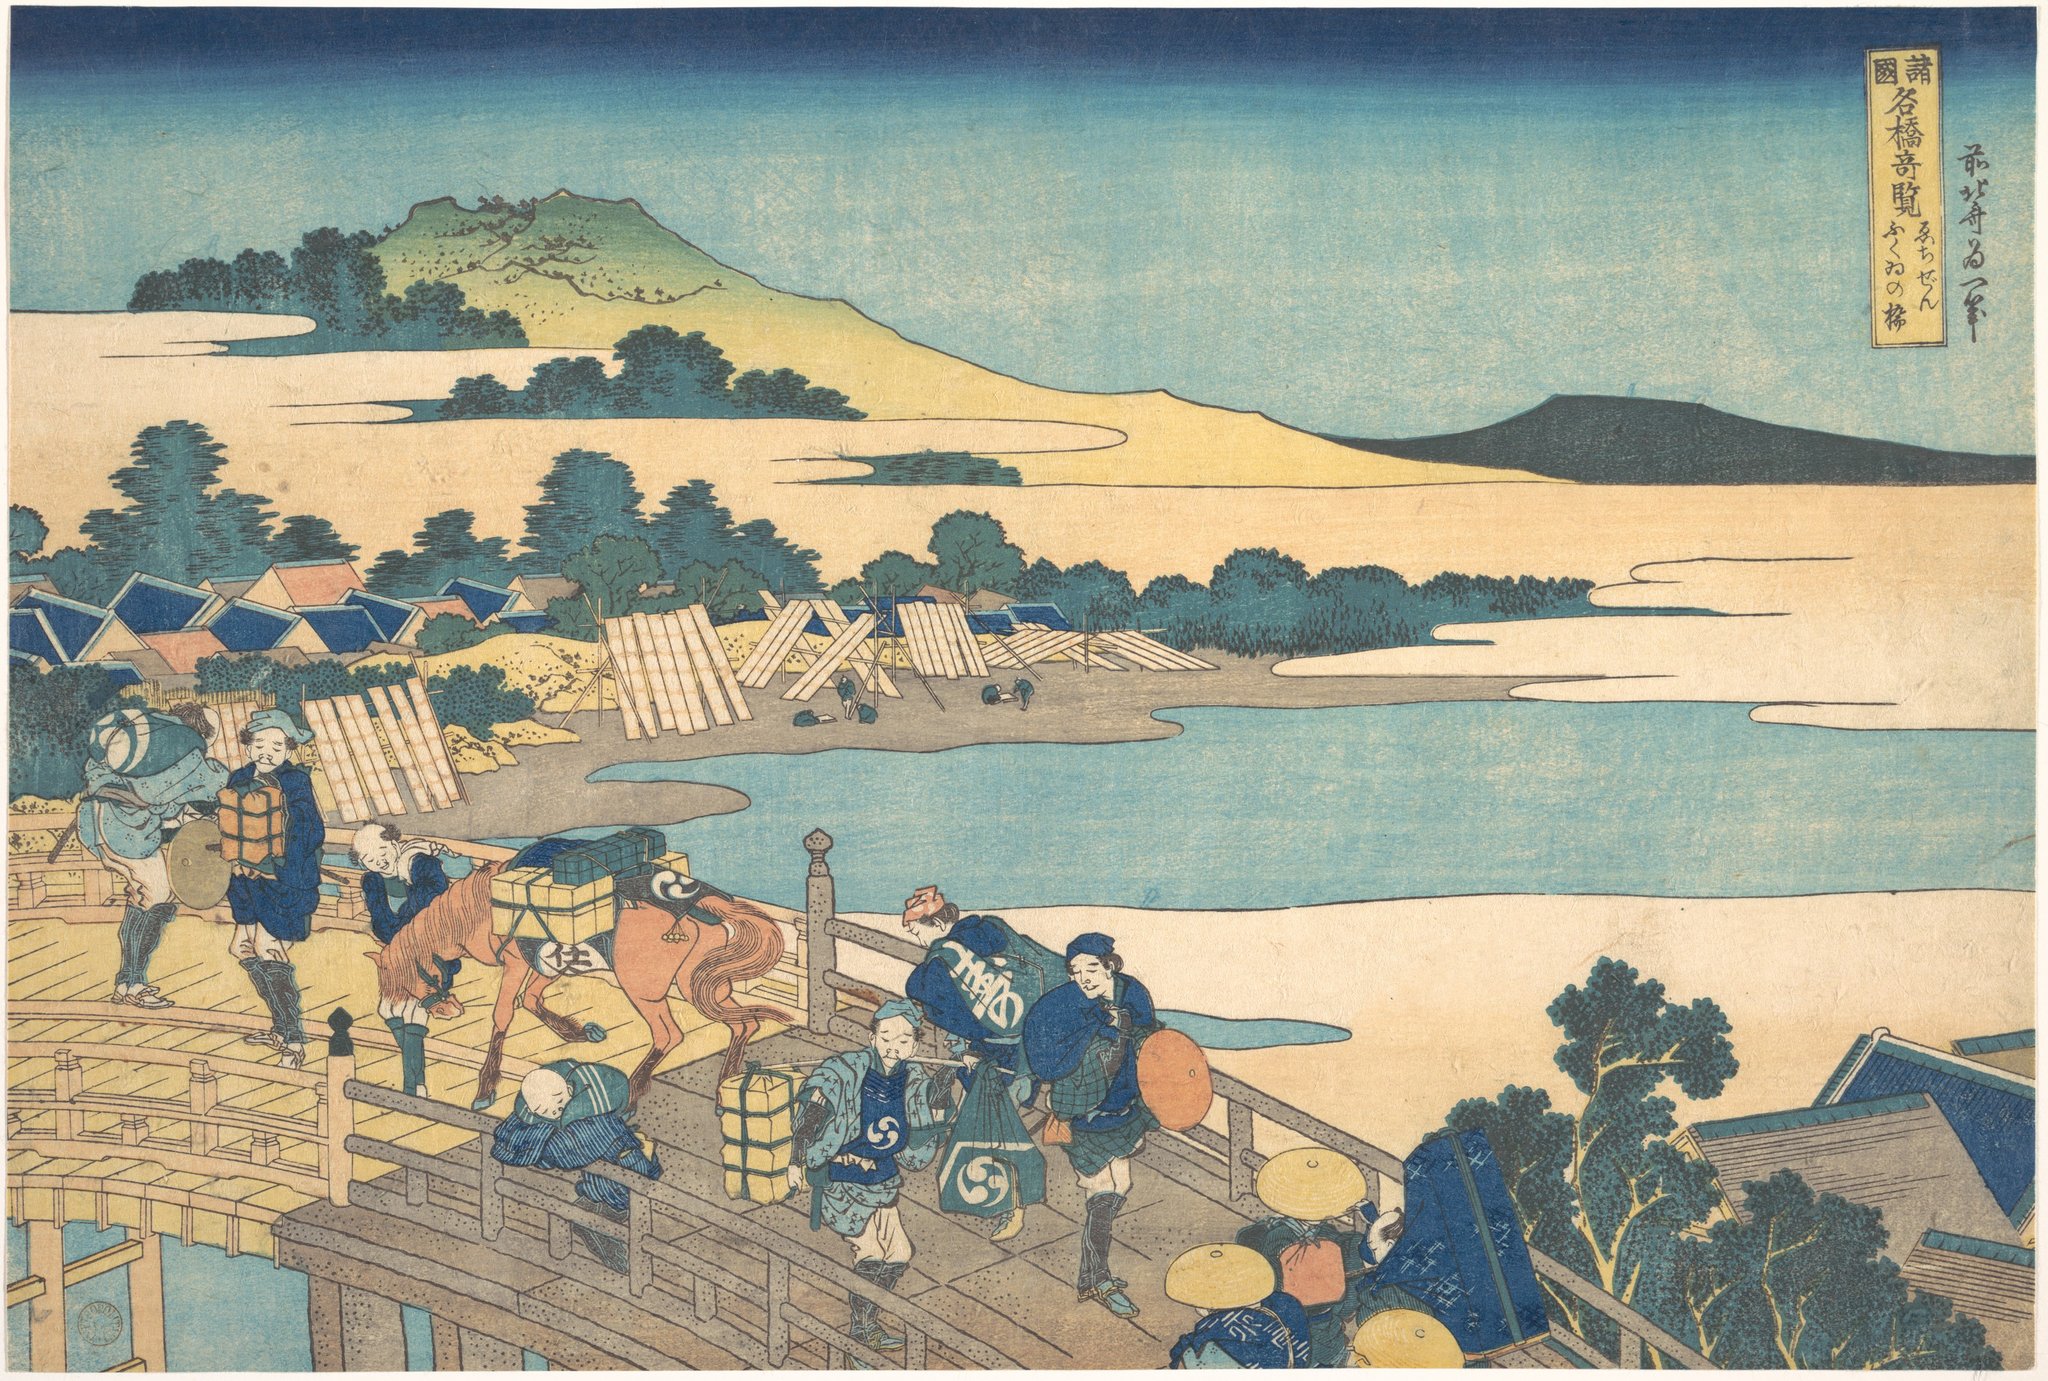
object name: woodblock print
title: Fukui Bridge in Echizen Province (Echizen Fukui no hashi), from the series Remarkable Views of Bridges in Various Provinces (Shokoku meikyō kiran)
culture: japanese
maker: katsushika hokusai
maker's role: artist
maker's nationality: japanese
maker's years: 1760-1849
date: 1827-1830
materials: ink, paper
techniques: woodblock print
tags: human figures,bridges,horses,hills,trees